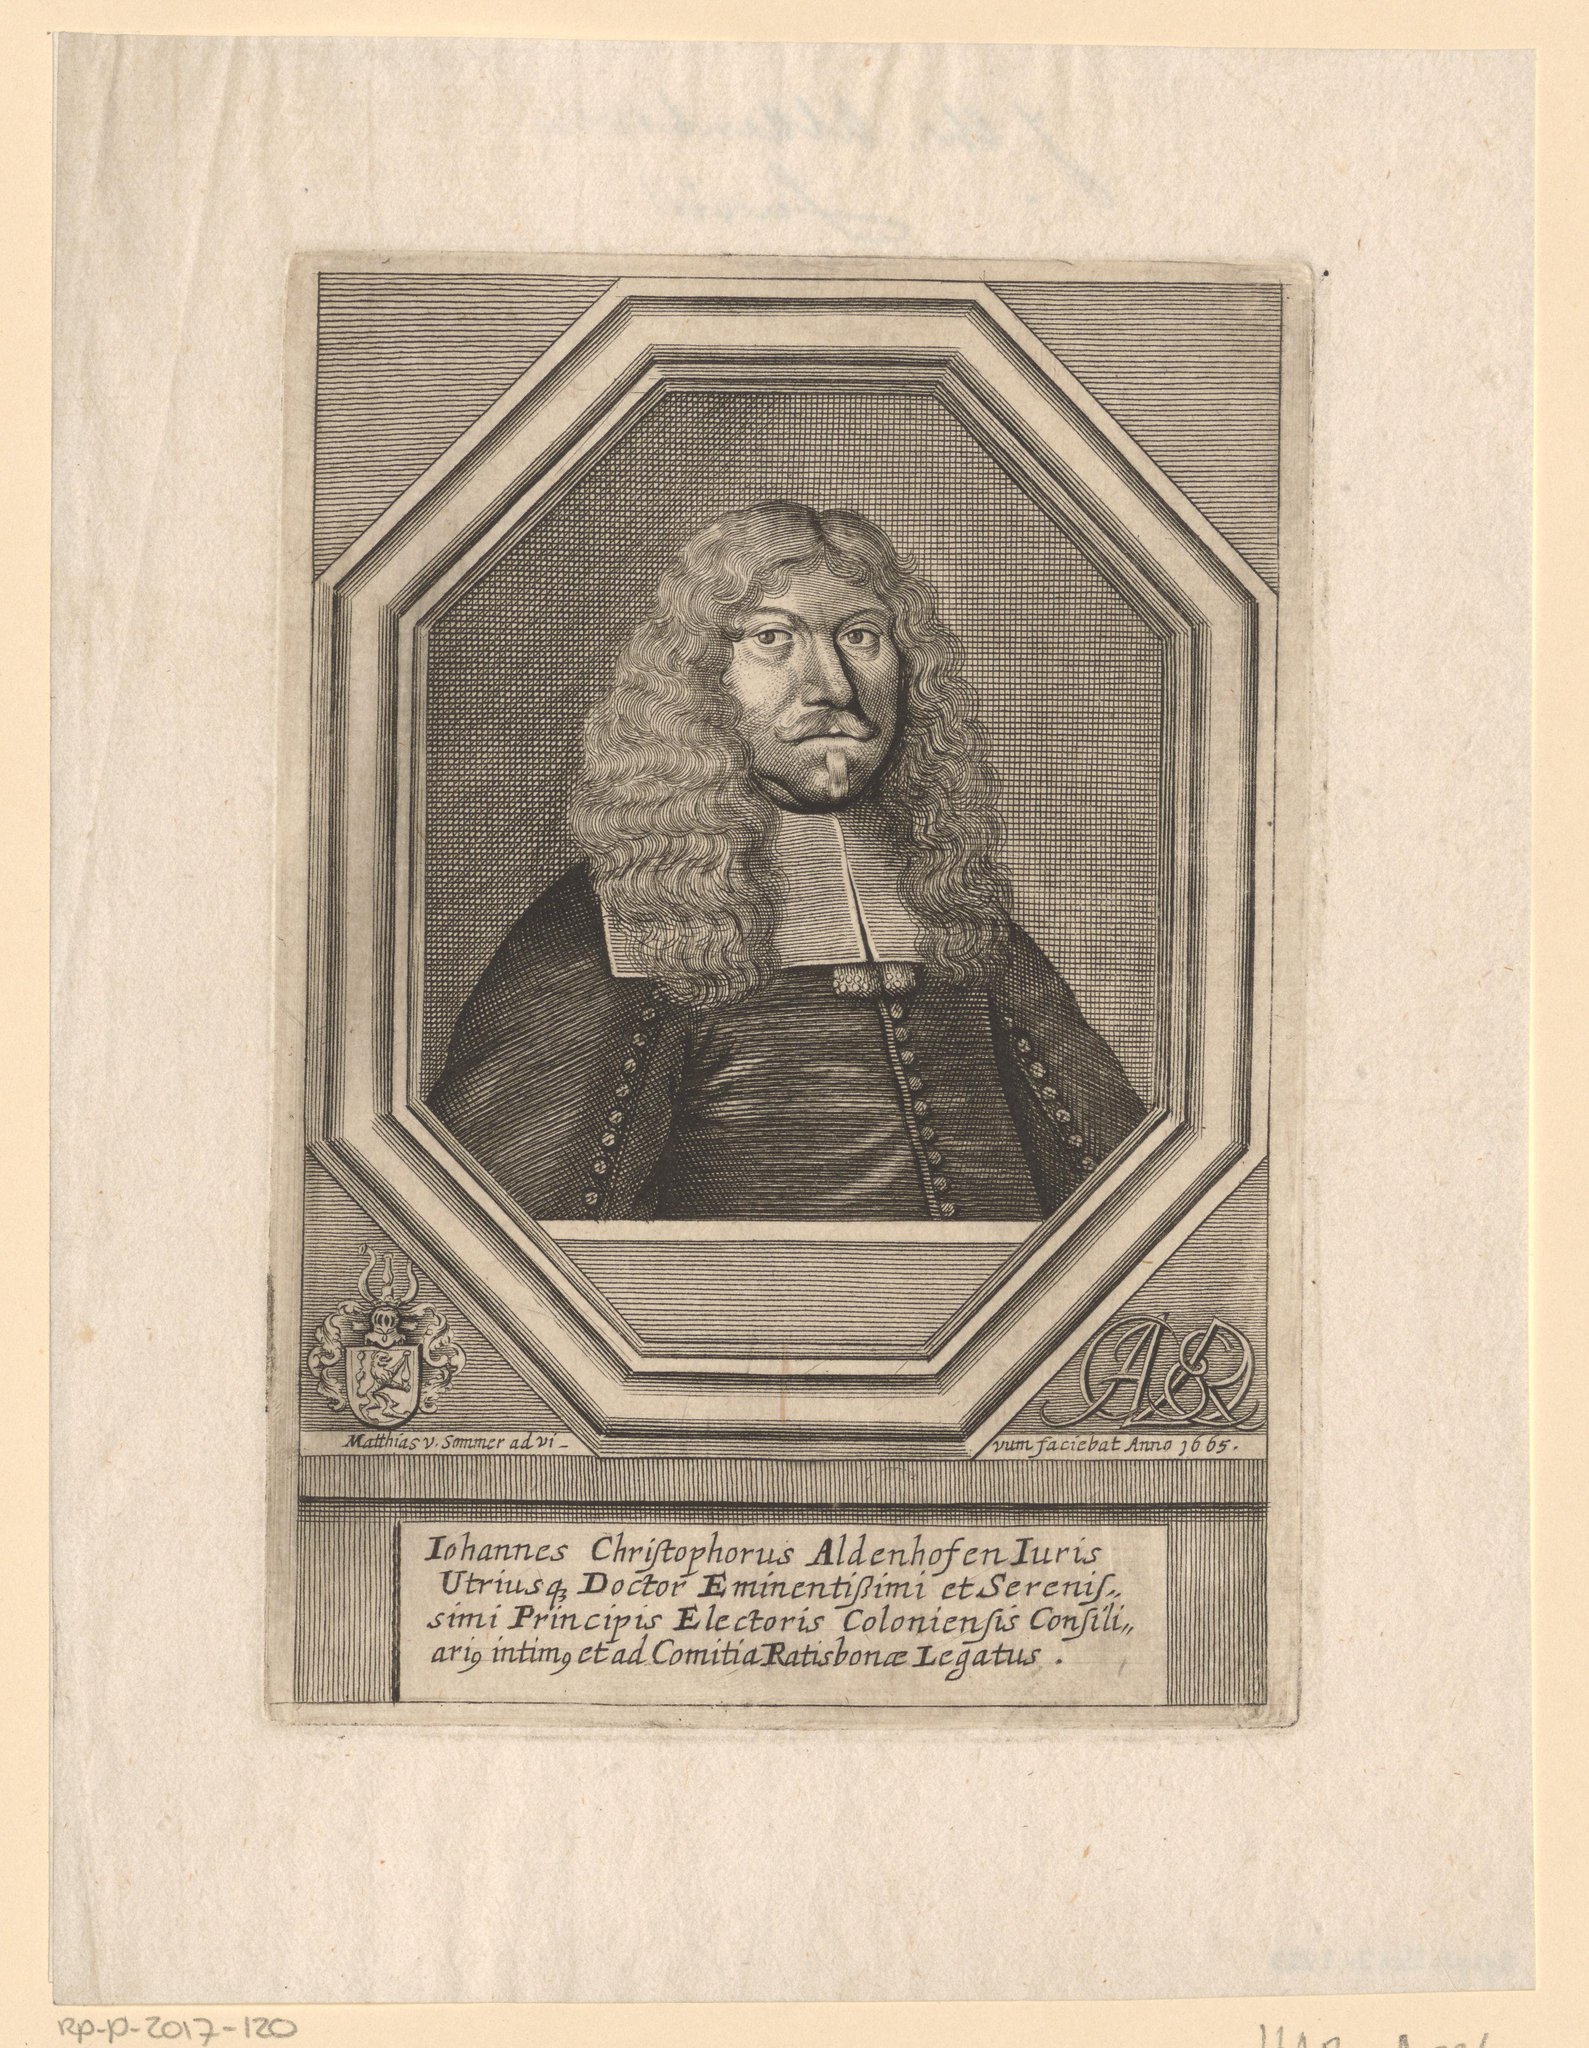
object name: print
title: Portret van Johann Christoph Aldenhoven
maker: matthias van sommer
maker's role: draughtsman, print maker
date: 1665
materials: paper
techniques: engraving, etching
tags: diplomaat, johann christoph aldenhoven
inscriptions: date